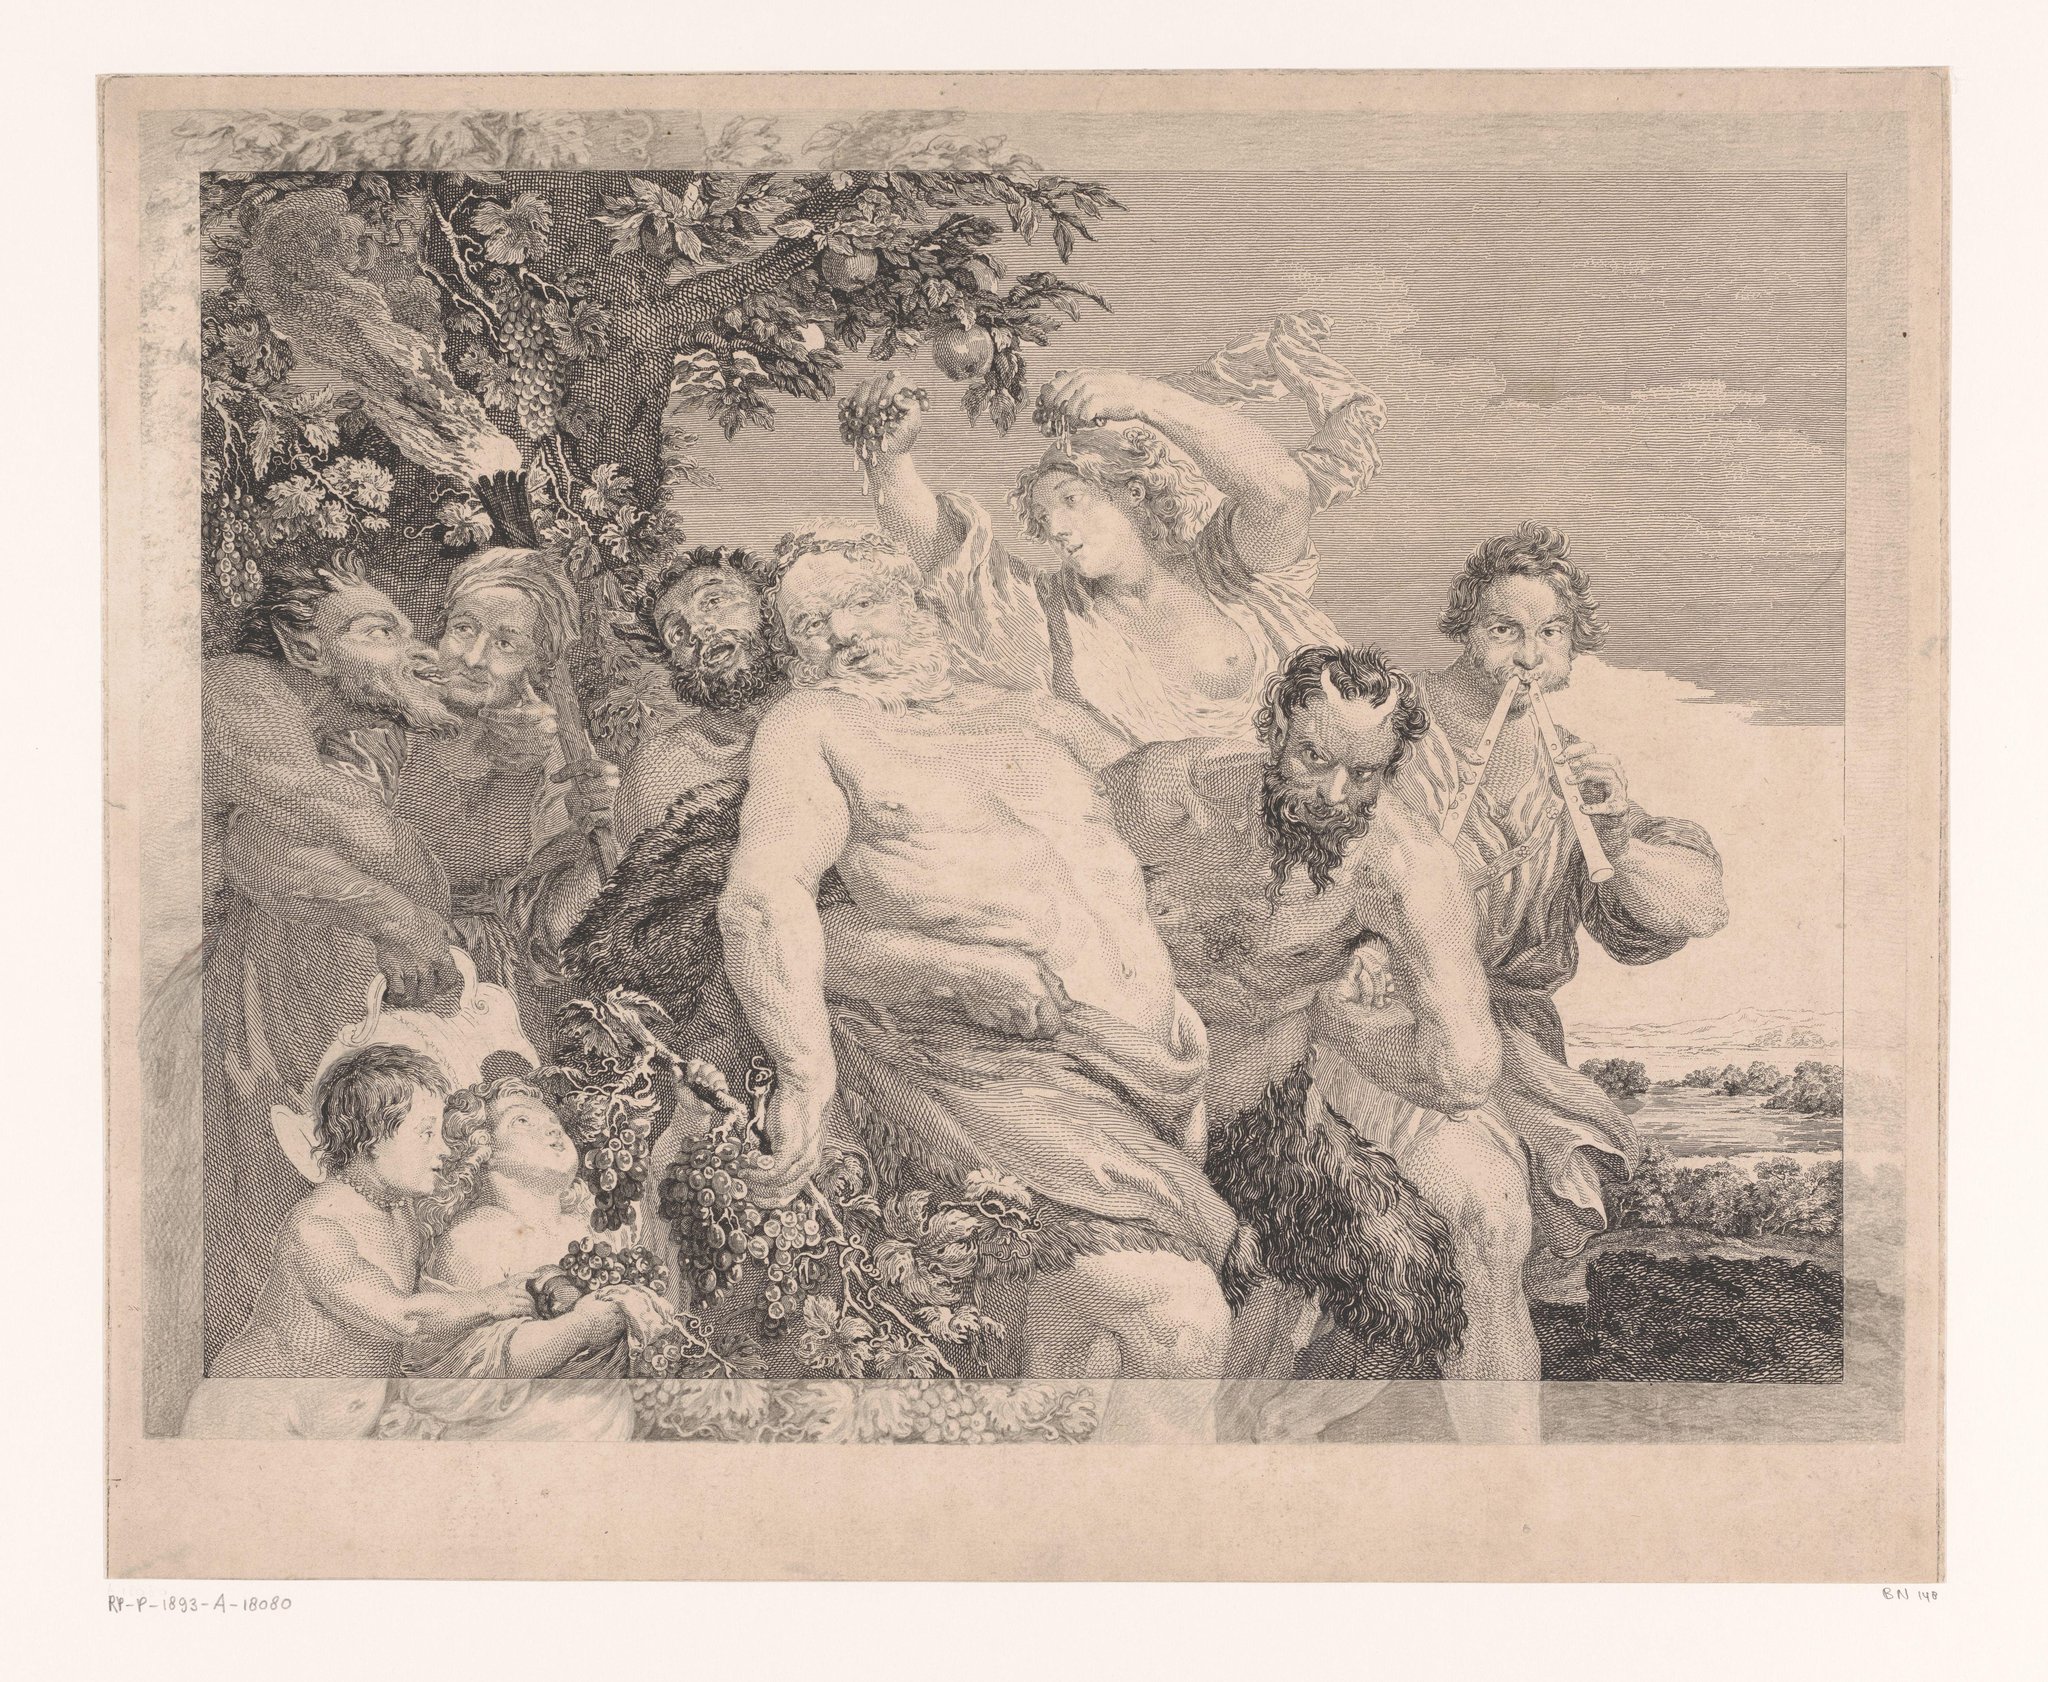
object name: print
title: Dronken Silenus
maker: nicolas delaunay (1739-1792)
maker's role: draughtsman, print maker, printer, publisher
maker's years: 1739-1792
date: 1777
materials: paper, pencil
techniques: etching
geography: france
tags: (story of) silenus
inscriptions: collector's mark: Lugt 2228